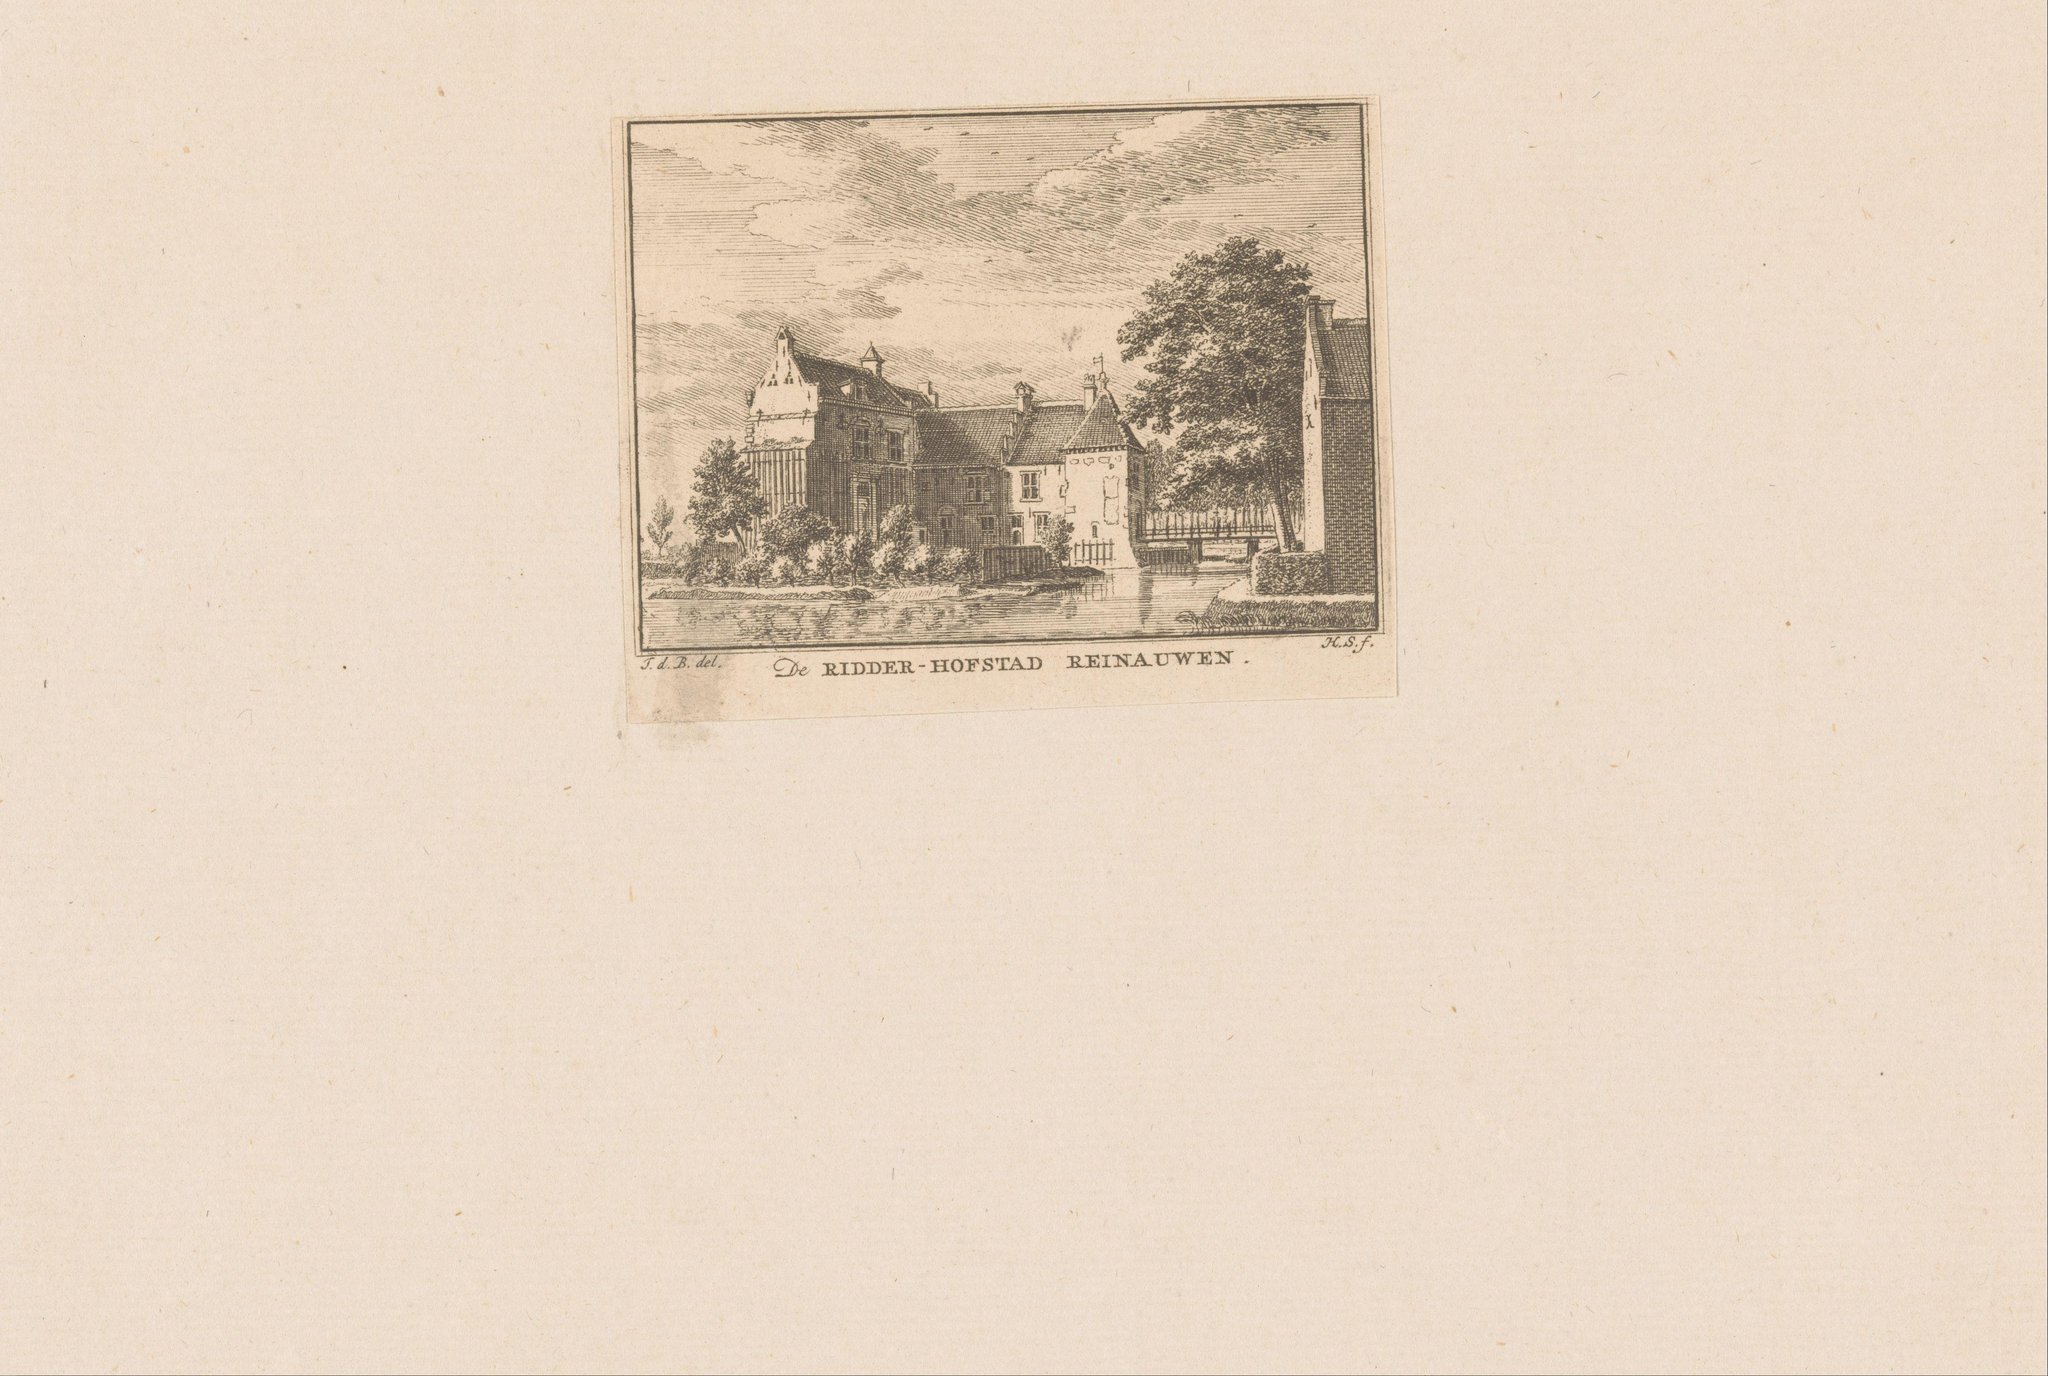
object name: book illustration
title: De ridder-hofstad Reinauwen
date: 1745-1774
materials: paper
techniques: engraving, etching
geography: amsterdam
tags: castle, landscape with tower or castle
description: Prent uit: Spilman, Hendrik. Het verheerlykt Nederland; of, kabinet van hedendaagsche gezigten (...). 9 dln. Amsterdam: Isaak Tirion, 1745-1774.